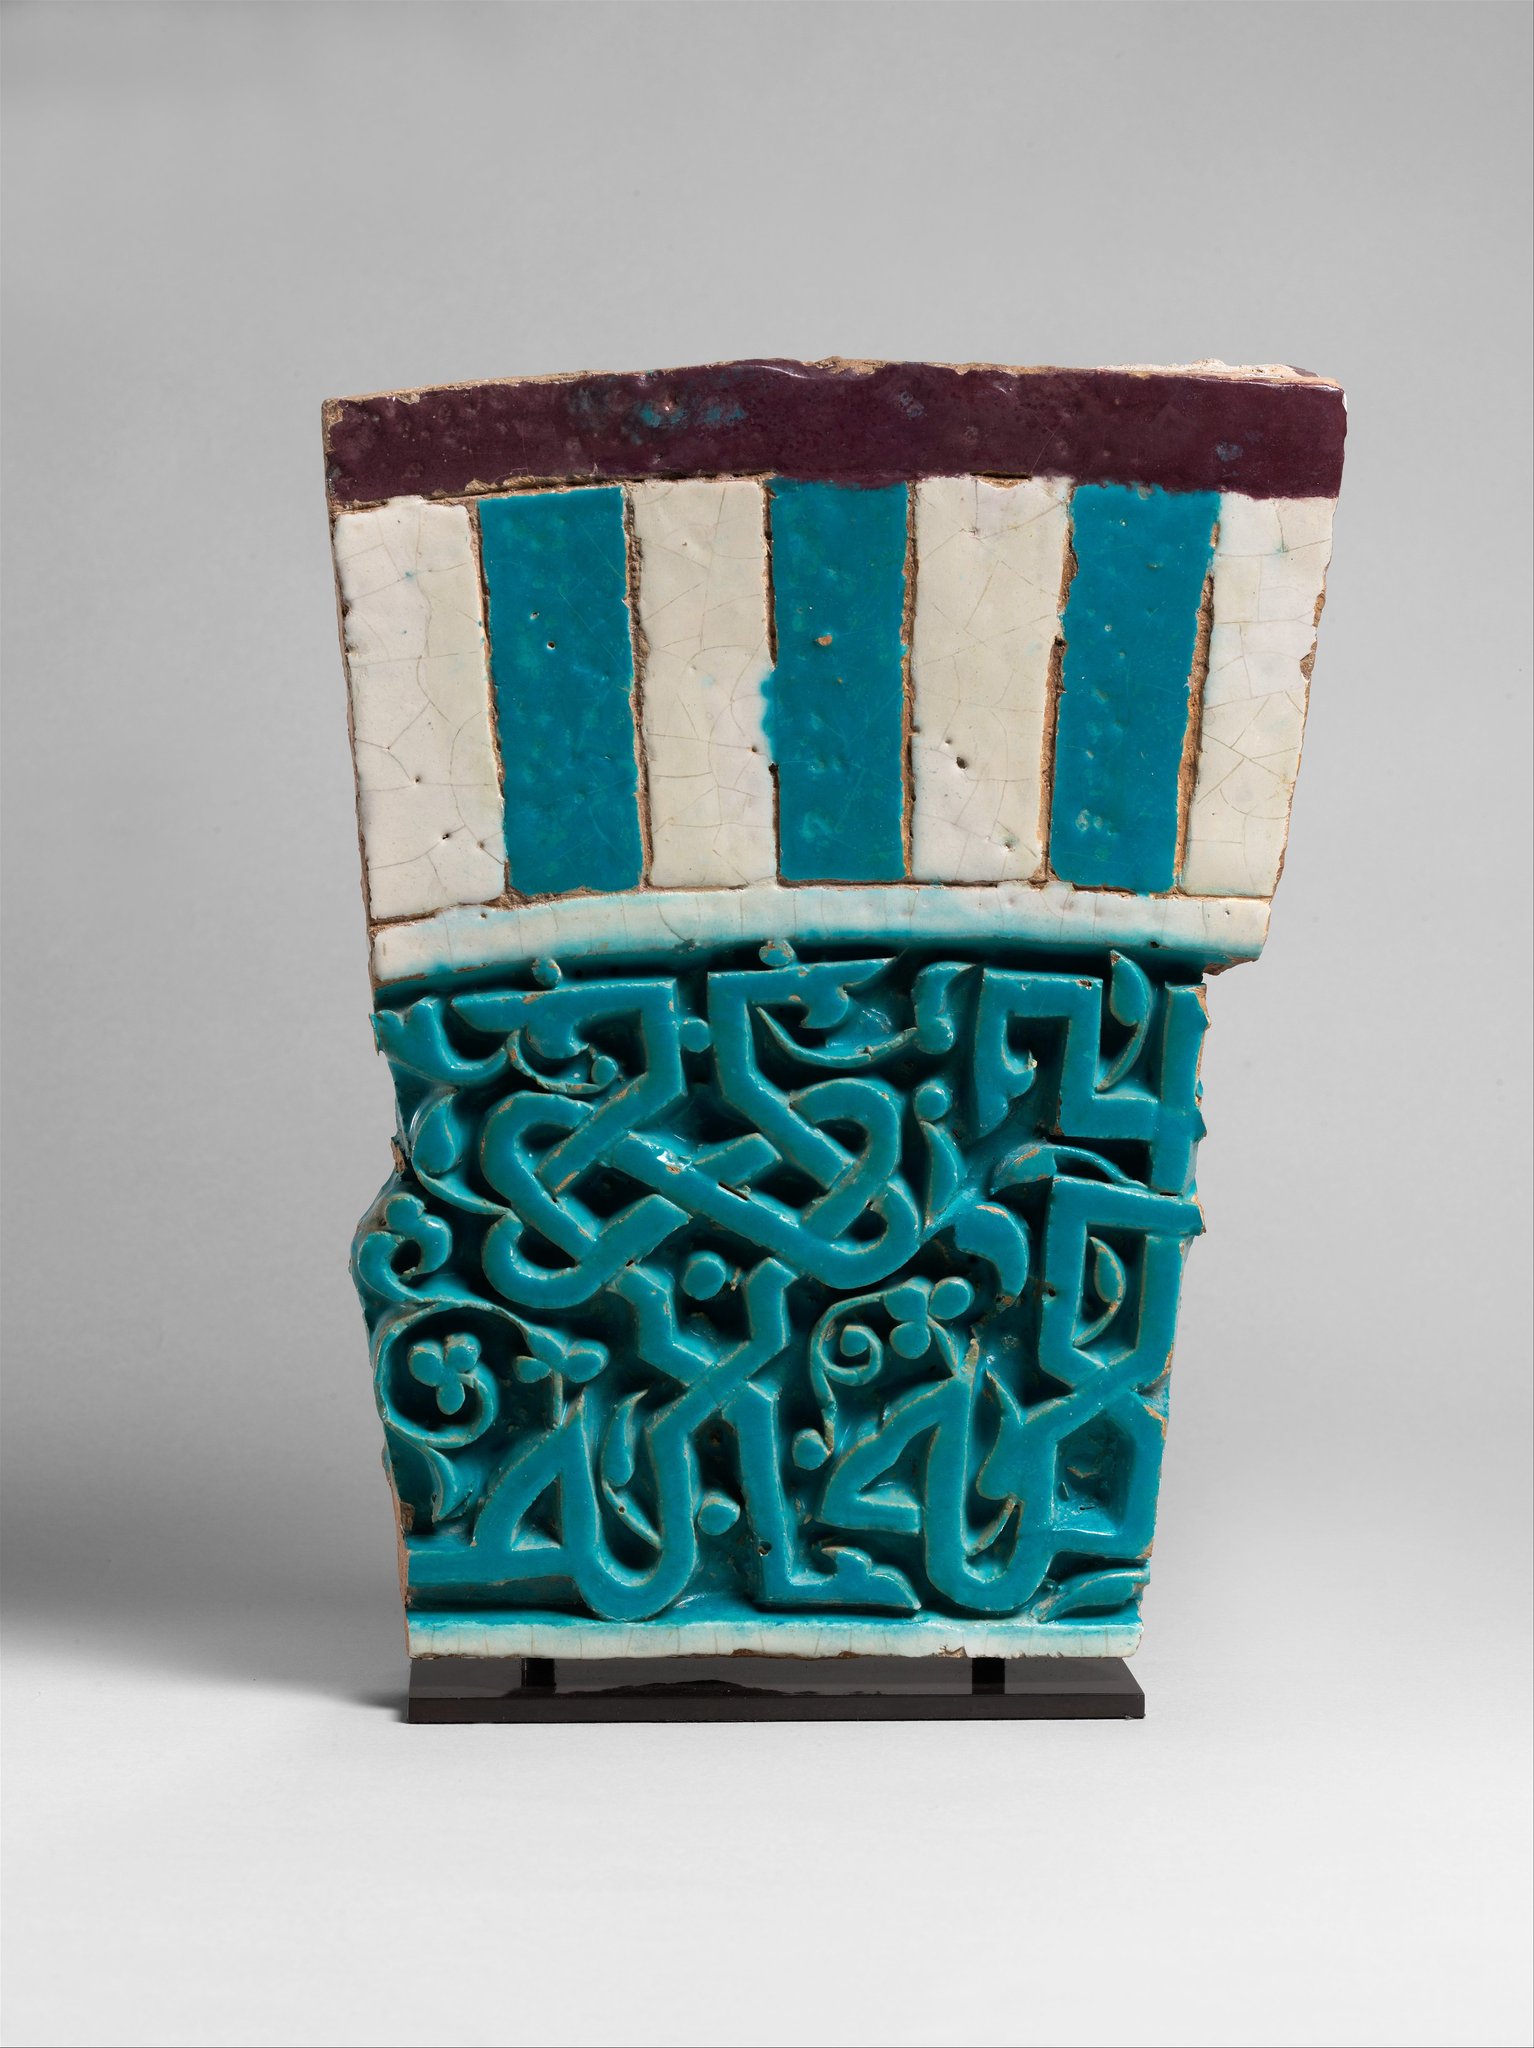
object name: tile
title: Architectural Tile with Partial Inscription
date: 1351-1400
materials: stonepaste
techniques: carving, glazing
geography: uzbekistan